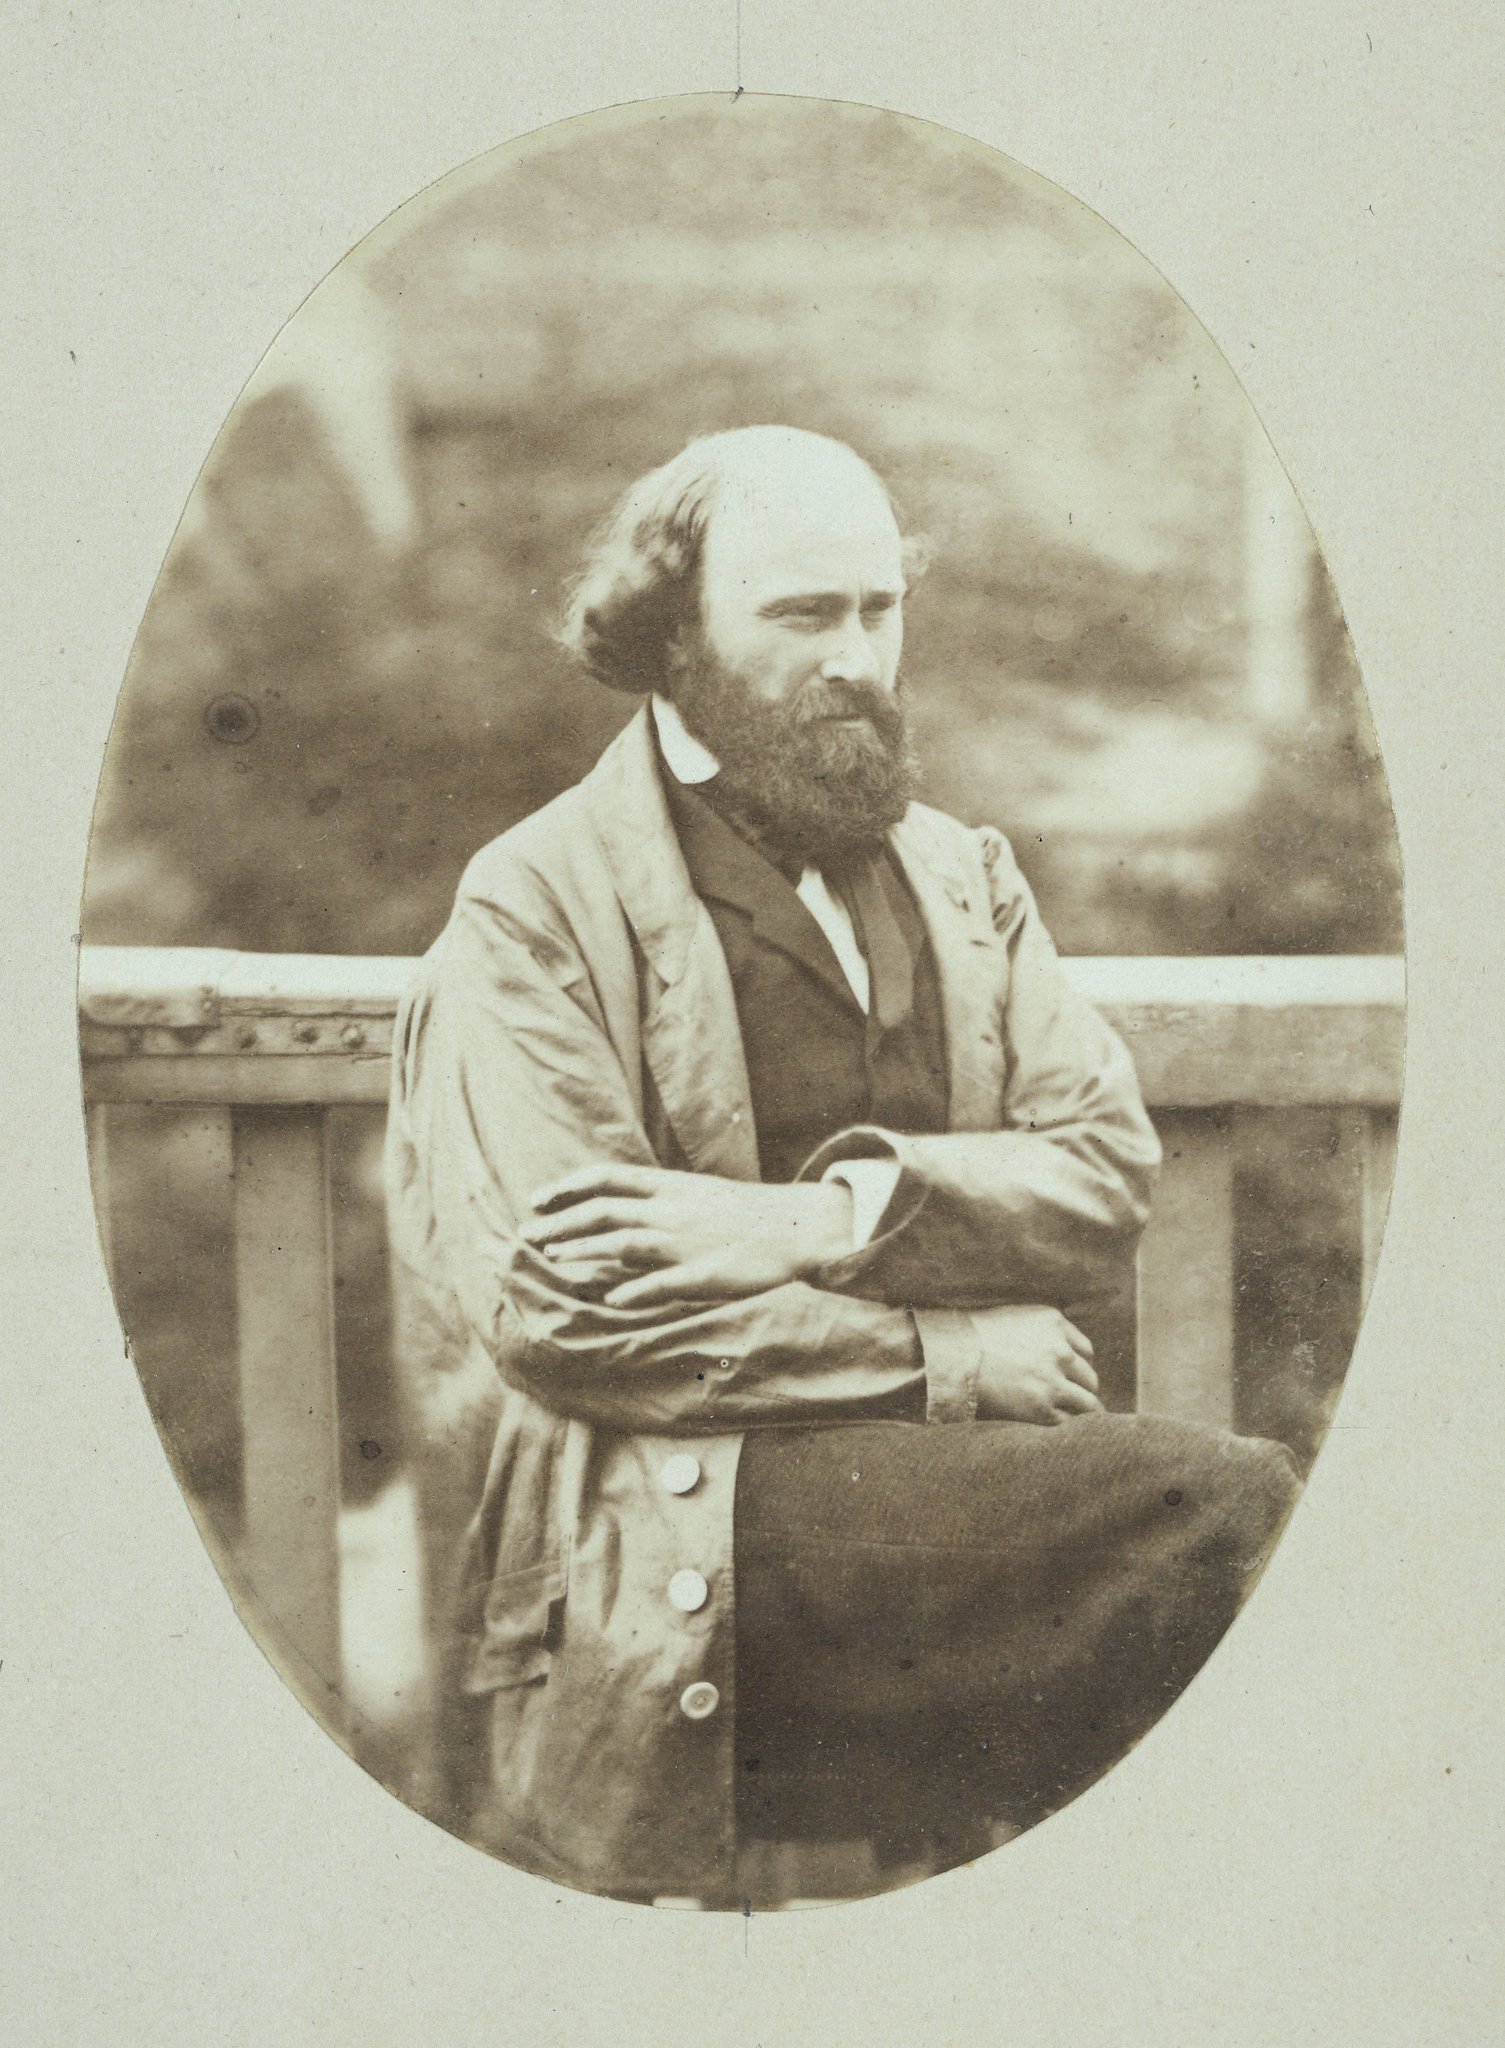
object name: photograph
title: Portret van Marie Eugène Bour voor de balustrade van de garancinefabriek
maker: eduard isaac asser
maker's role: amateurfotograaf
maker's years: 1809-1894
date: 1852-1860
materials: cardboard, paper, photographic support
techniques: salted paper print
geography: amsterdam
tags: engineer, manufacturer, marie eugène bour, historical persons - bb - woman, amsterdam